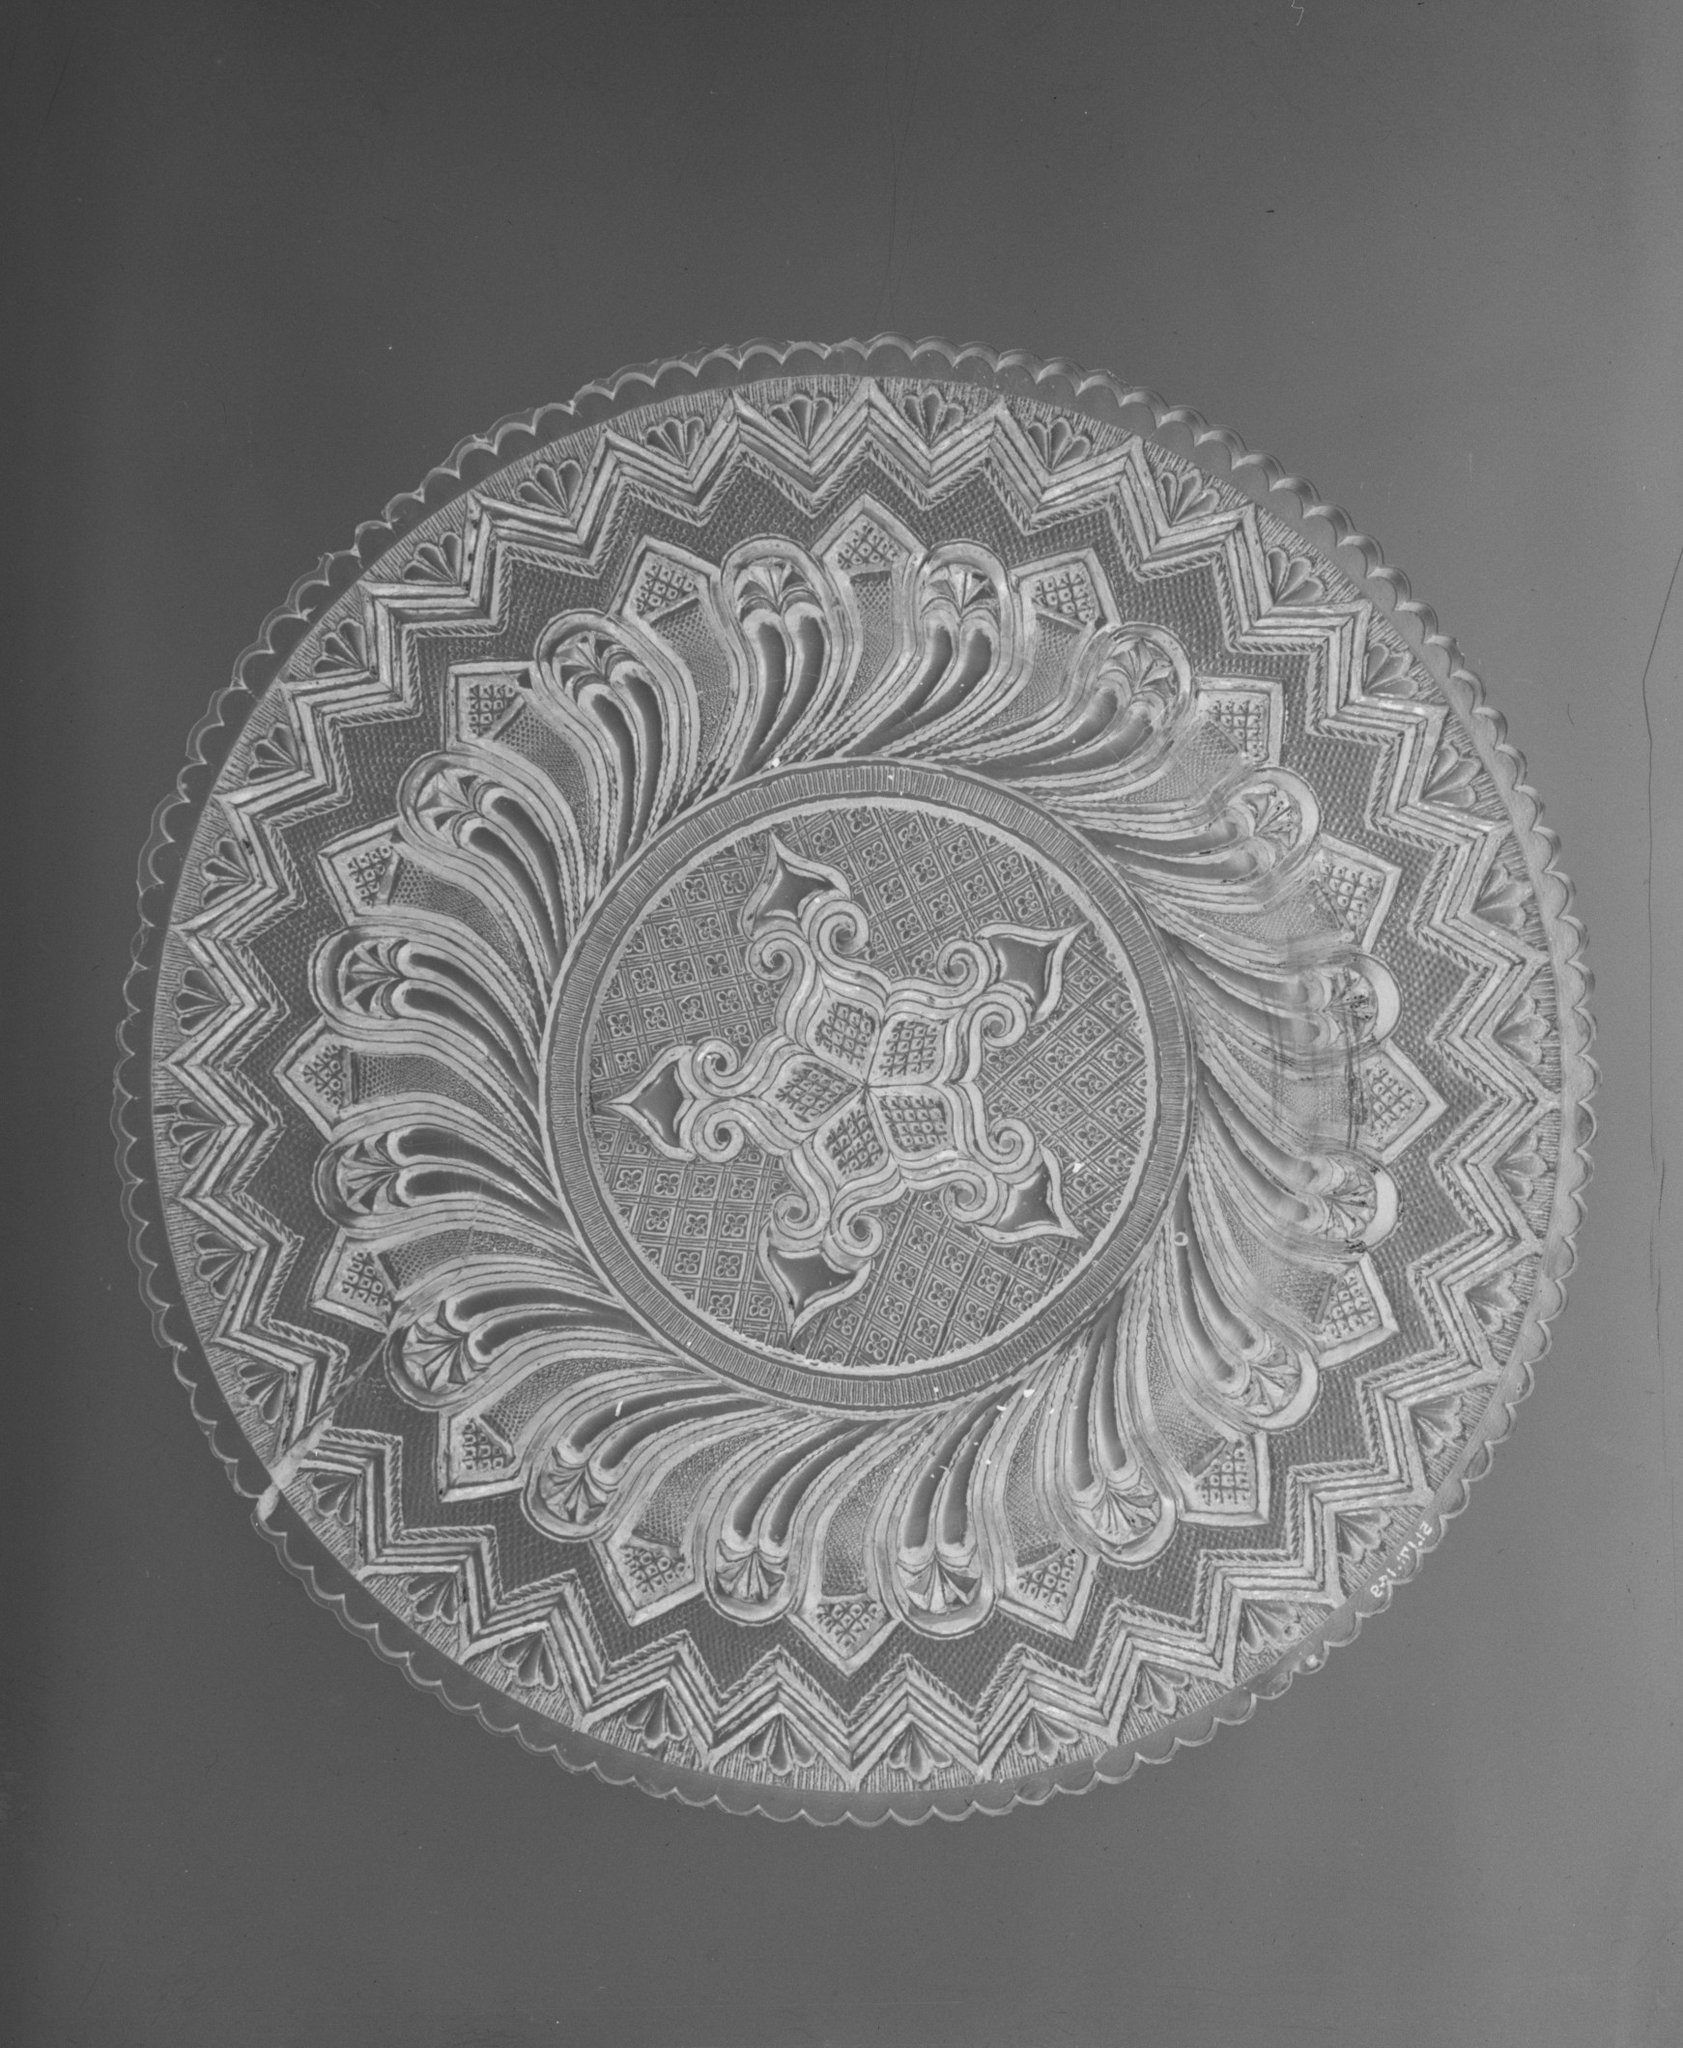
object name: dish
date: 1800-1900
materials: glass